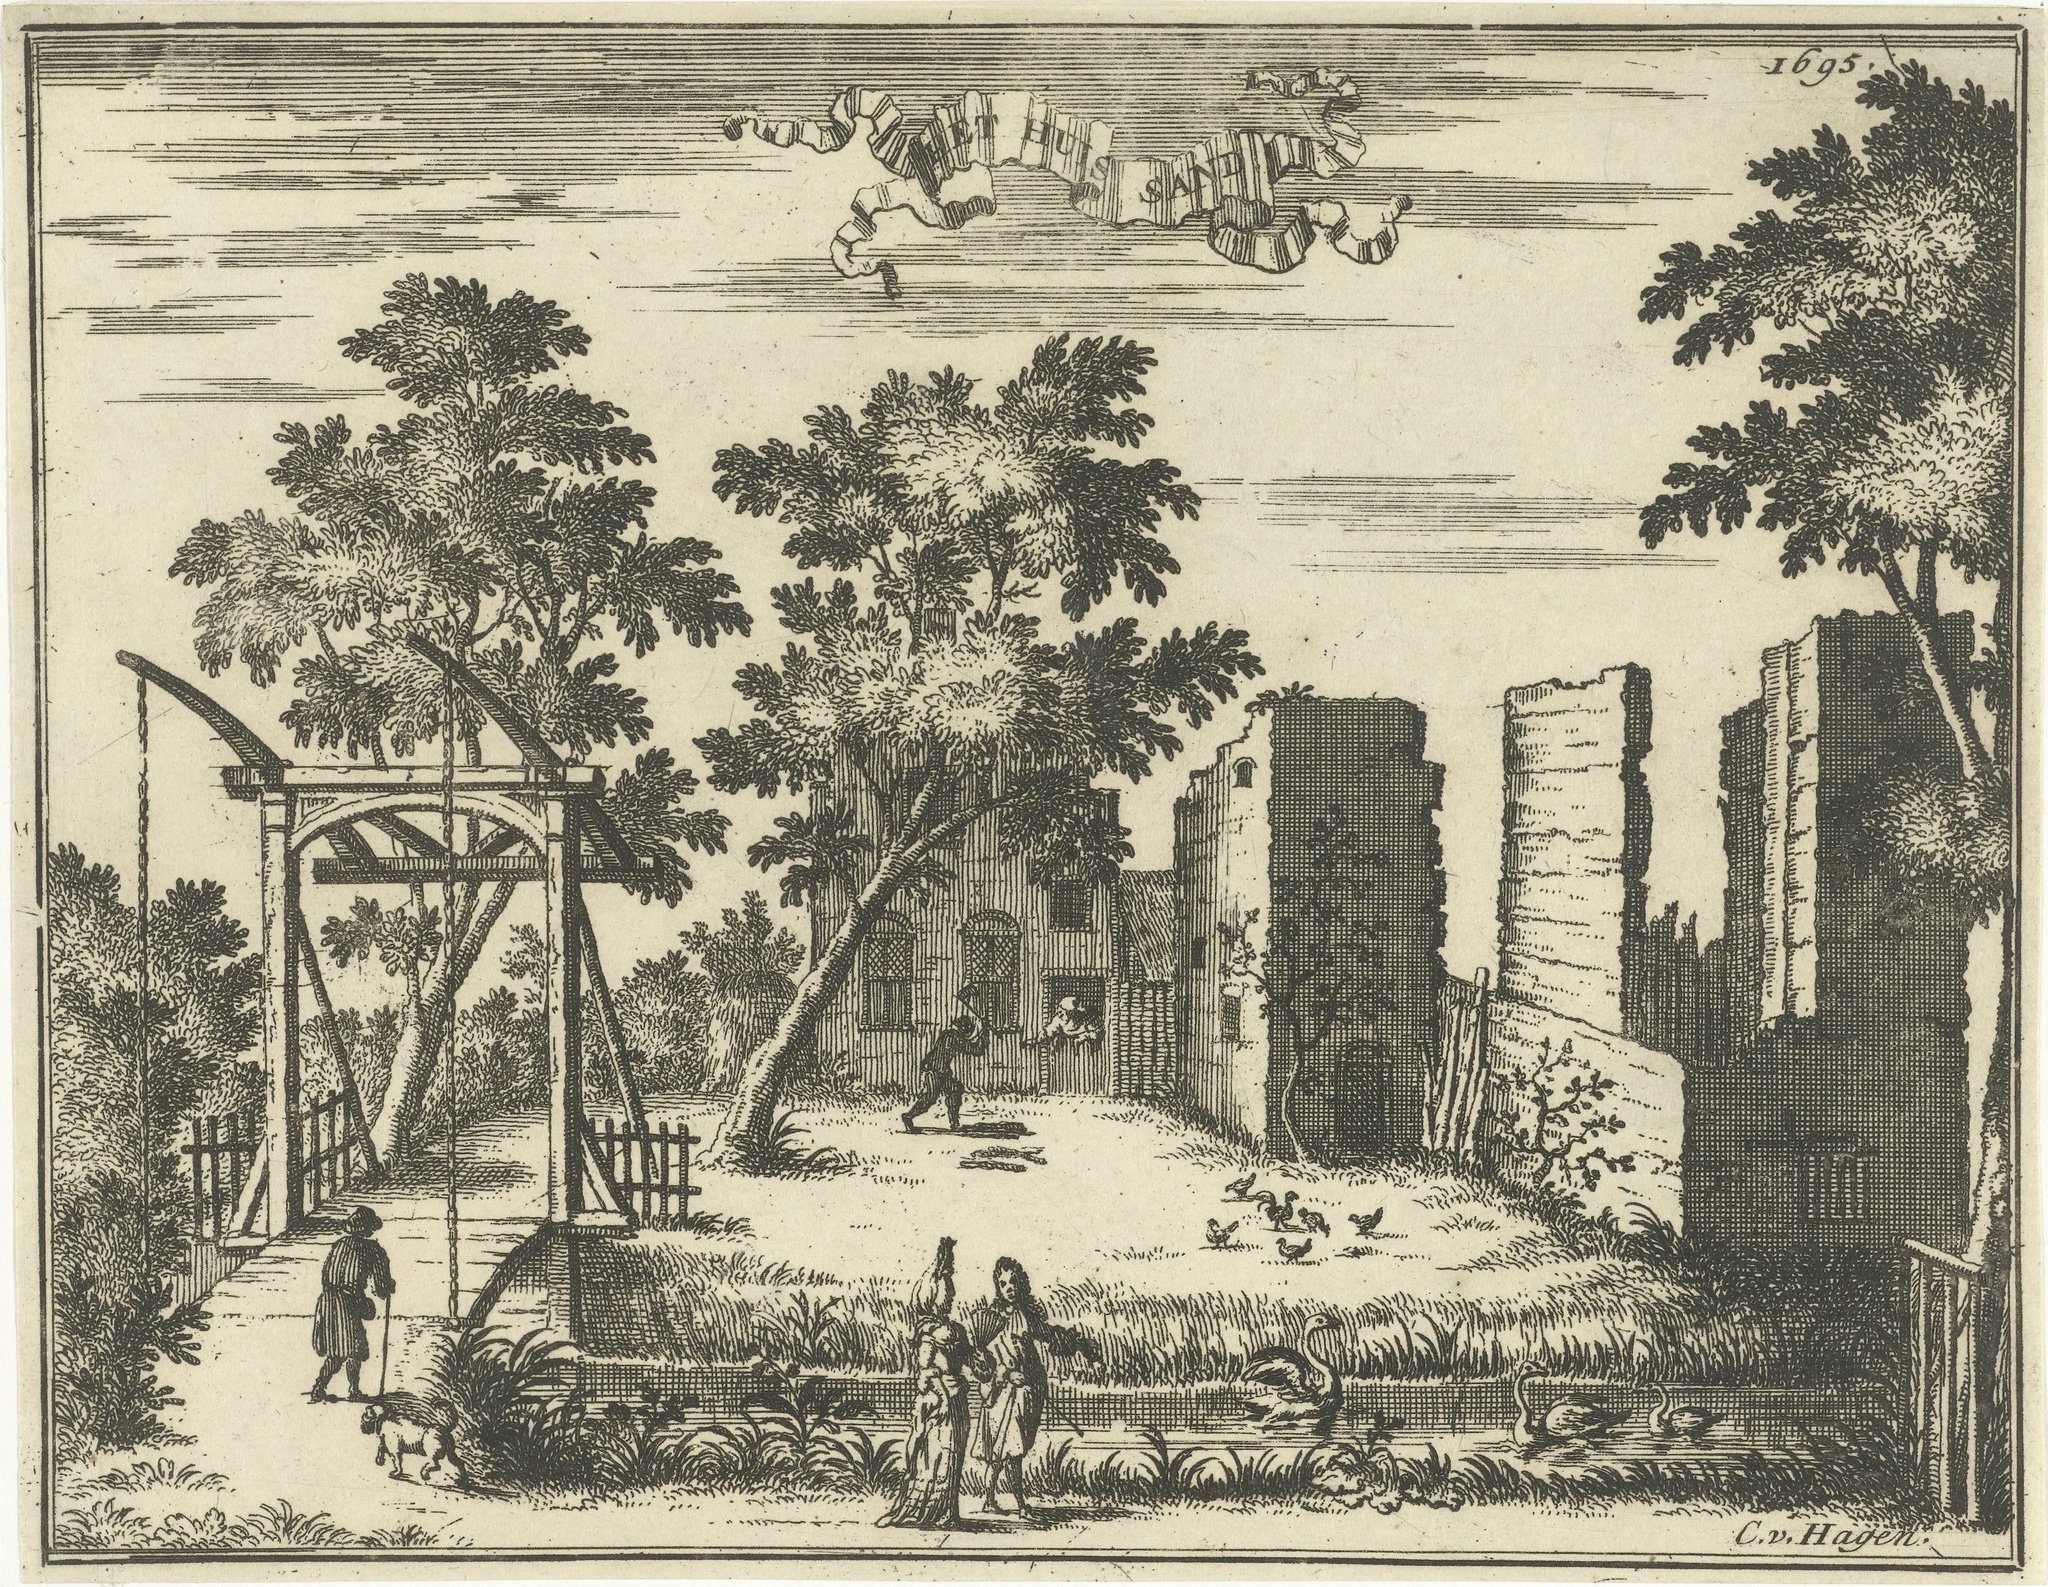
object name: print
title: Figuren bij een ruïne en een ophaalbrug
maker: christiaan hagen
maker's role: draughtsman, print maker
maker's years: 1635-1707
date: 1695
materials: paper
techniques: etching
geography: amsterdam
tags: bridge, landscape with ruins (+ city(-scape) with figures, staffage)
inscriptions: collector's mark: Lugt 2228